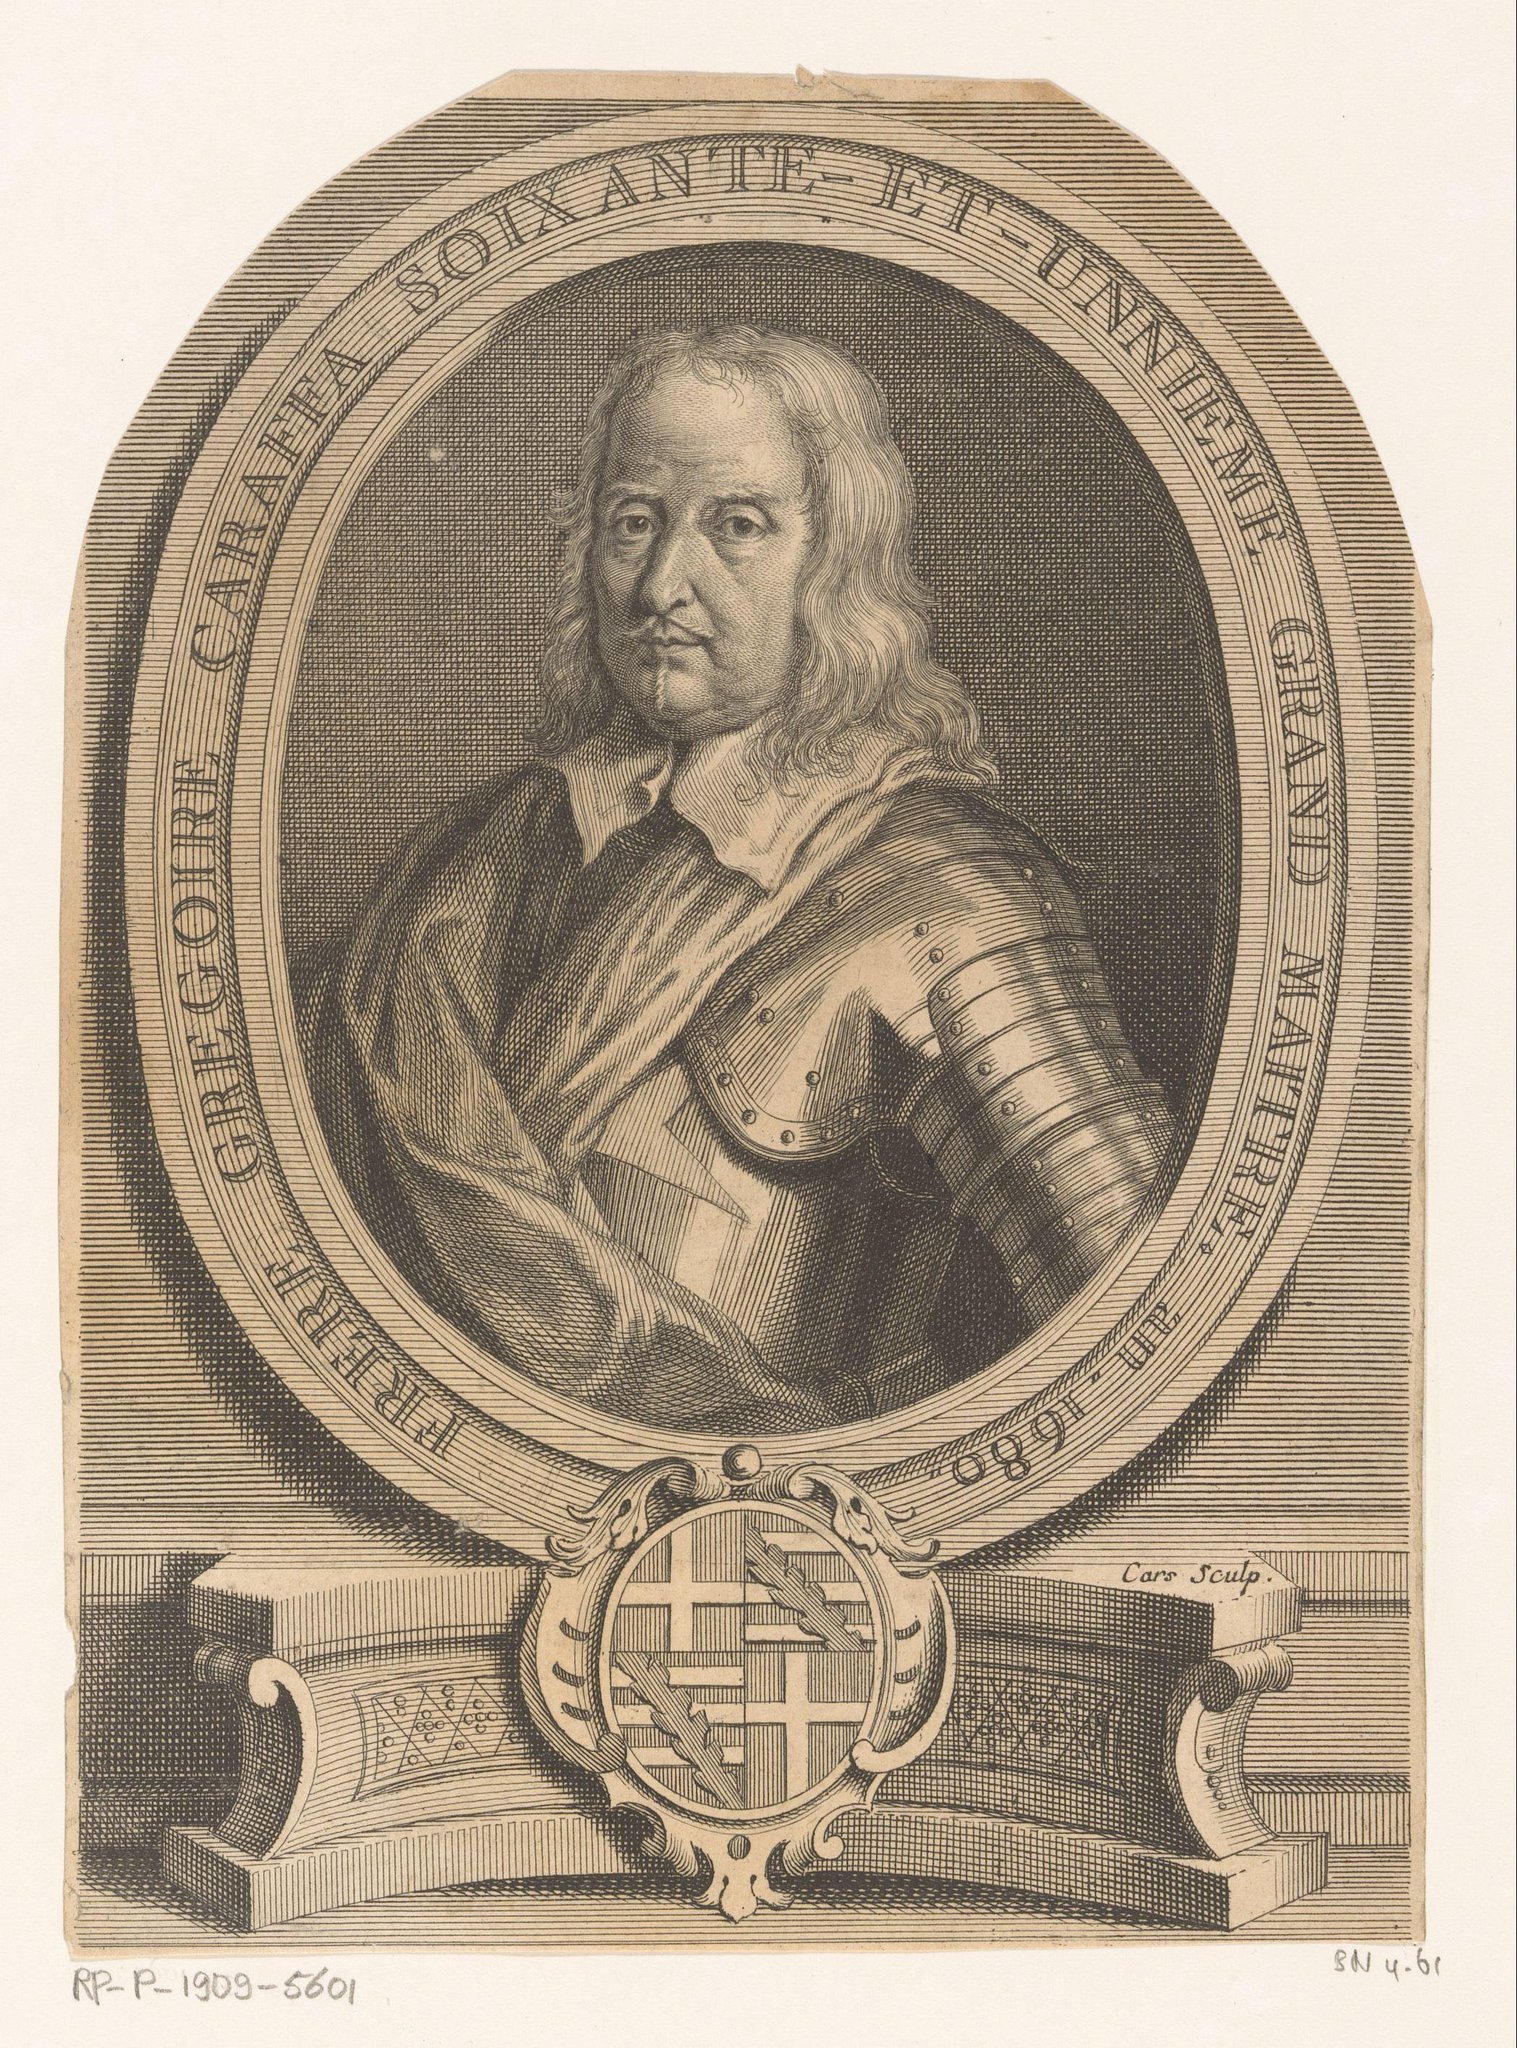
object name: book illustration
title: Gregoire Caraffa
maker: laurent cars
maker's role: print maker, publisher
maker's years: 1699-1771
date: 1726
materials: paper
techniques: engraving, etching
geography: france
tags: historical persons, military orders, e.g.: knights templars, knights of malta, teutonic knights ~ roman catholic church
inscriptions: collector's mark: Lugt 2228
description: Prent uit: Vertot, René Aubert de. Histoire des Chevaliers hospitaliers de St Jean de Jérusalem. Parijs: Rollin, Quillau, Desaint, 1726. Illustratie op p. 206 van deel 4. Cars vervaardigde portretten van 65 grootmeesters van de Maltezer Orde.